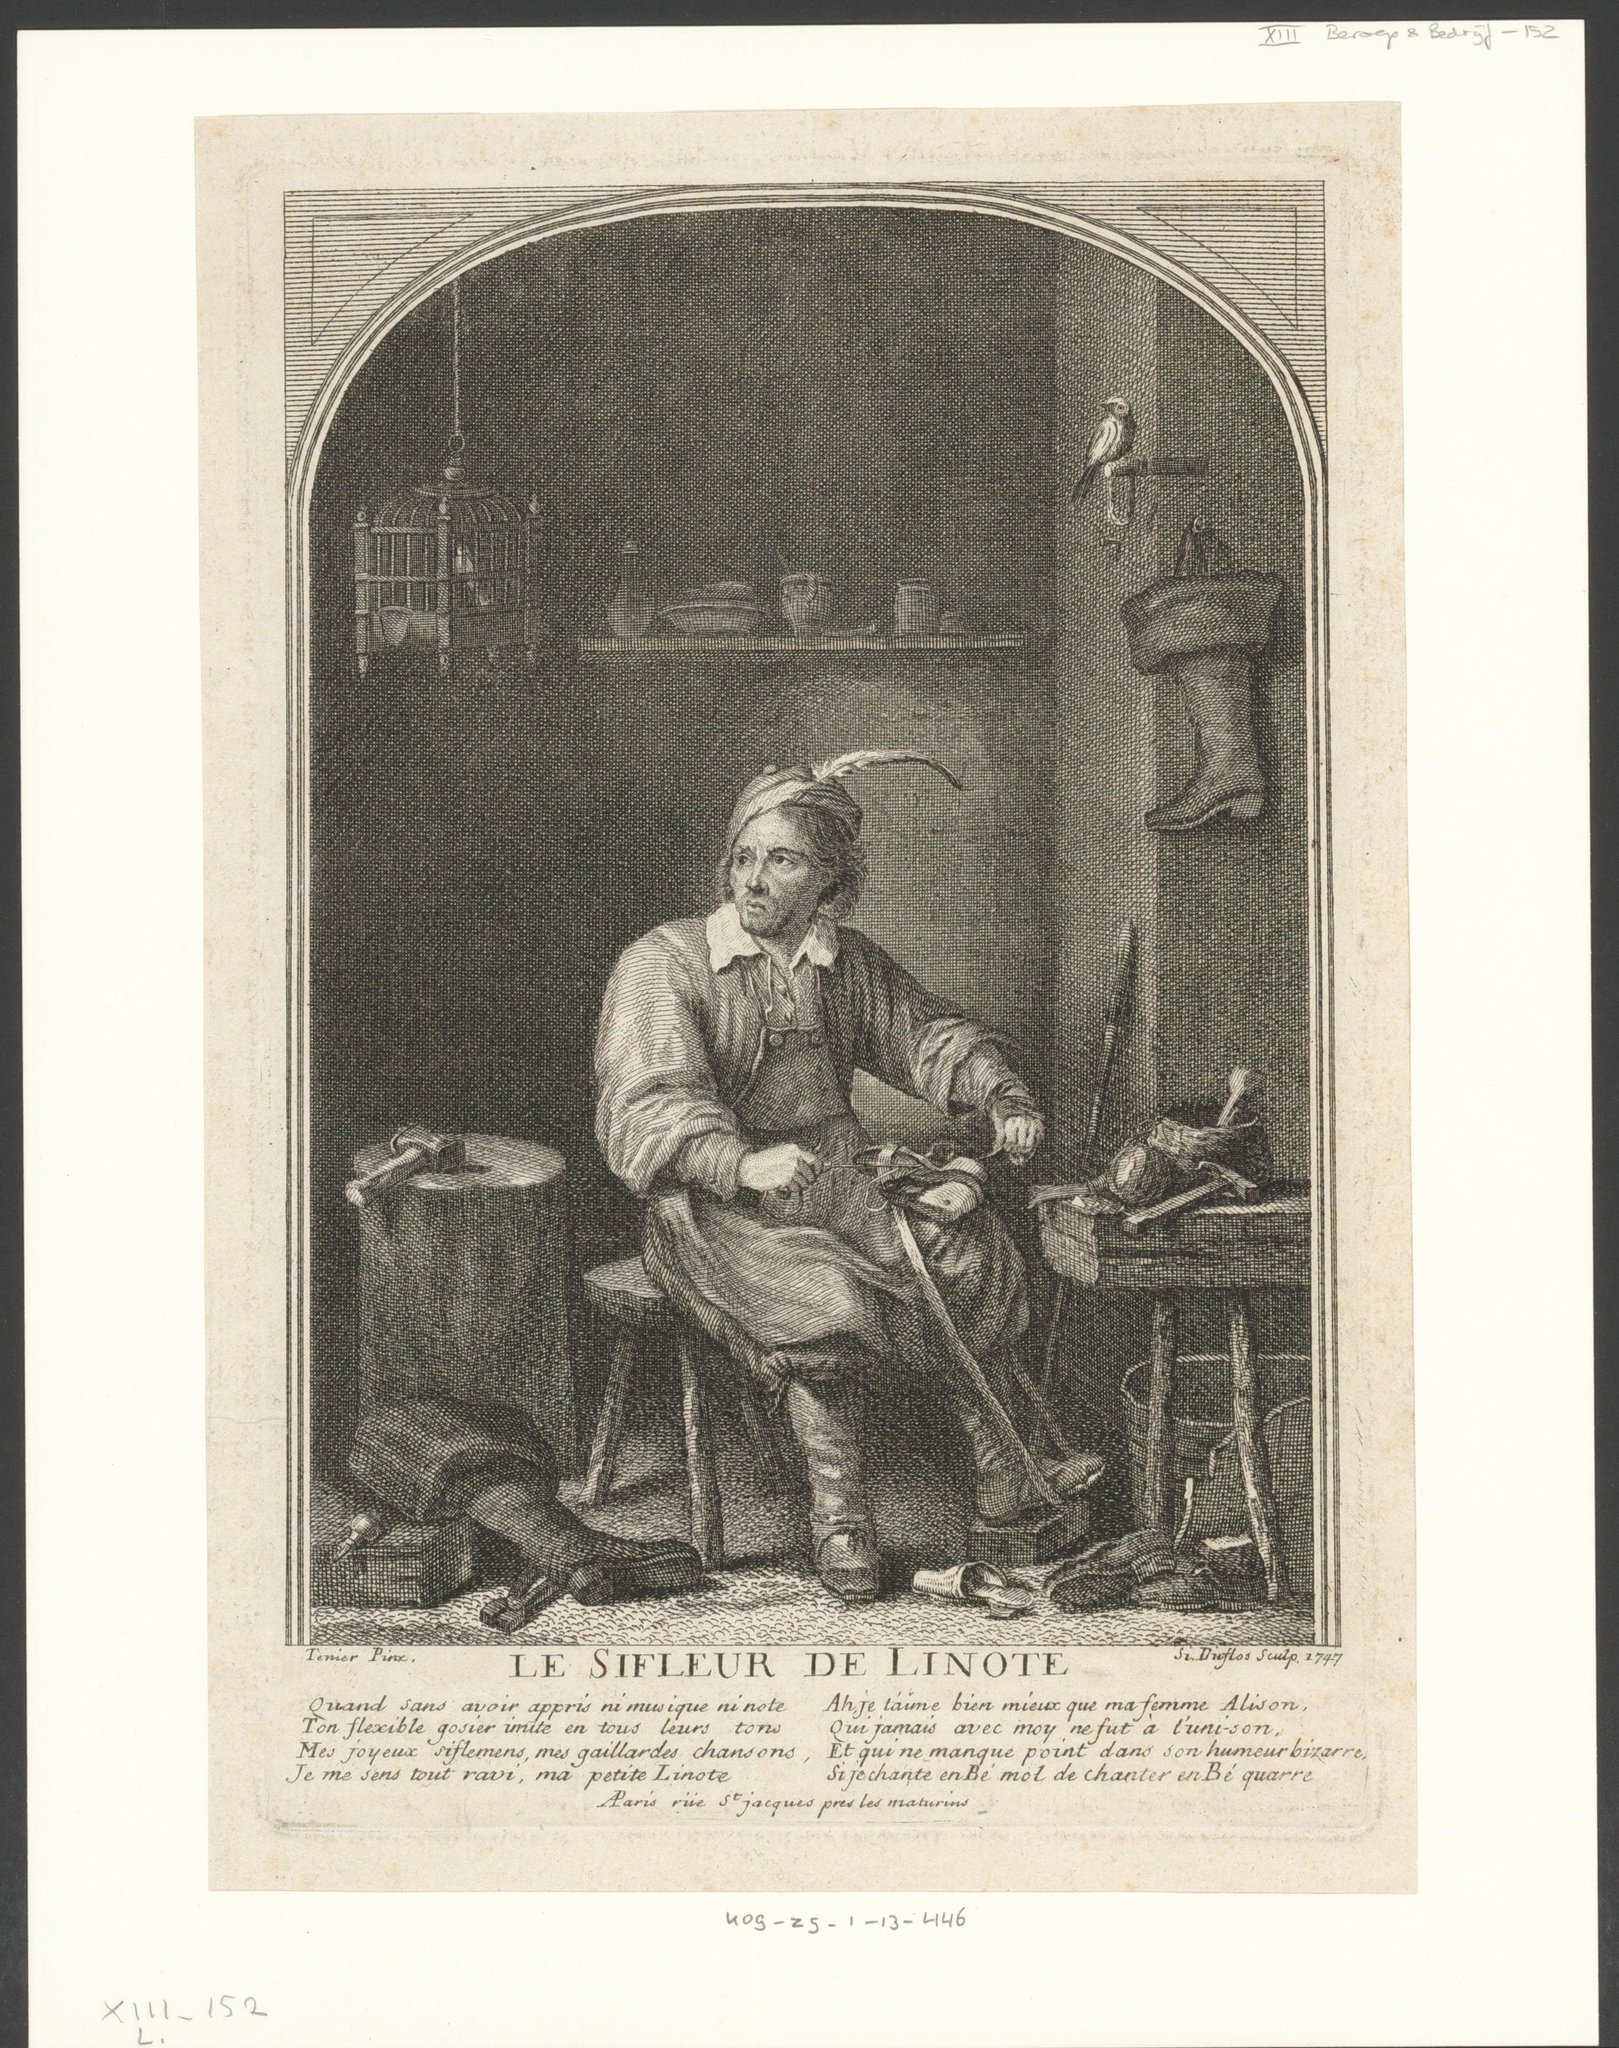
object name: print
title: Schoenmaker aan het werk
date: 1747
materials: paper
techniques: engraving, etching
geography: paris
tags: shoe-maker, cobbler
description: Onderaan een achtregelig vers. Onderwerpsrubrieken binnen de Atlas Zeden en Gewoonten: Handel, Nijverheid en verkeer, Beroep en bedrijf, Mannelijk, Bewerkers van het leder.